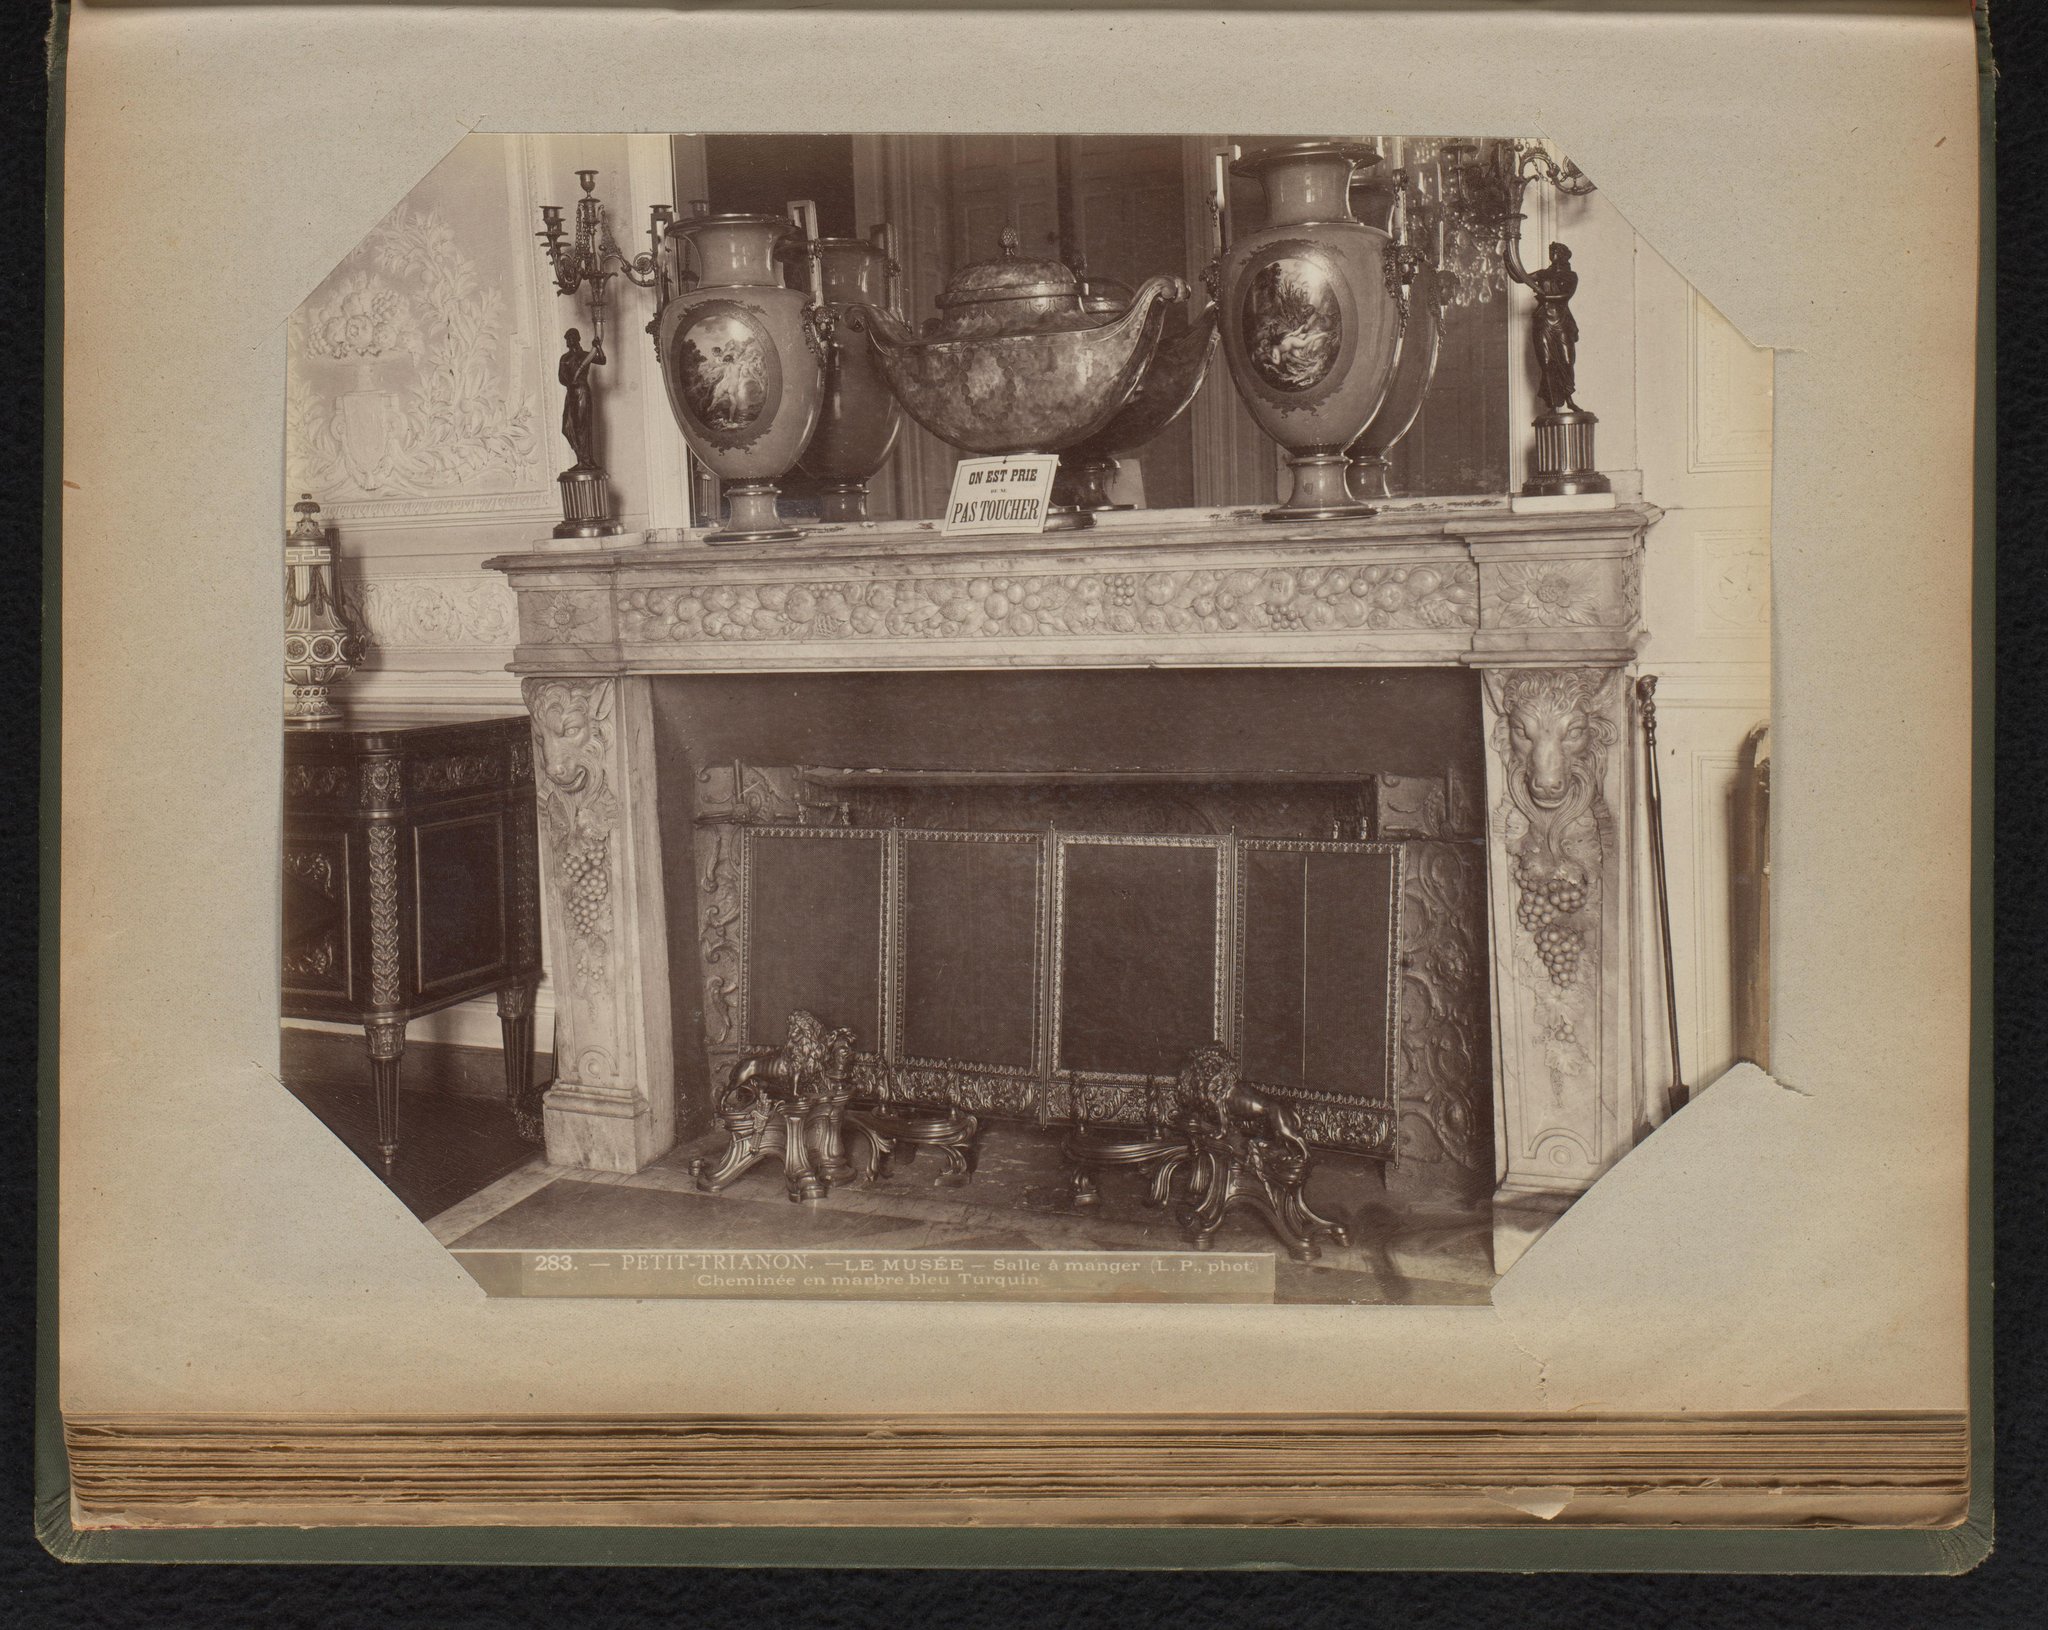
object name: photograph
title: 283. - Petit Trianon - Le Musee - Salle a manger (l.p. phot) (Cheminee en marbre bleu turquin).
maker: Anonymous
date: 1860-1900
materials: paper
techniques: albumen print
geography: france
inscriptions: annotation: ‘283. - Petit Trianon - Le Musee - Salle a manger (l.p. phot) (Cheminee en marbre bleu turquin).’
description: De schouw is in de bovenste balk voorzien van fruit decoraties, aan de zijkanten zijn schapenkoppen en druiventrossen zichtbaar. Het kaststel bestaat uit een middenvaas en twee beschilderde zijvazen.